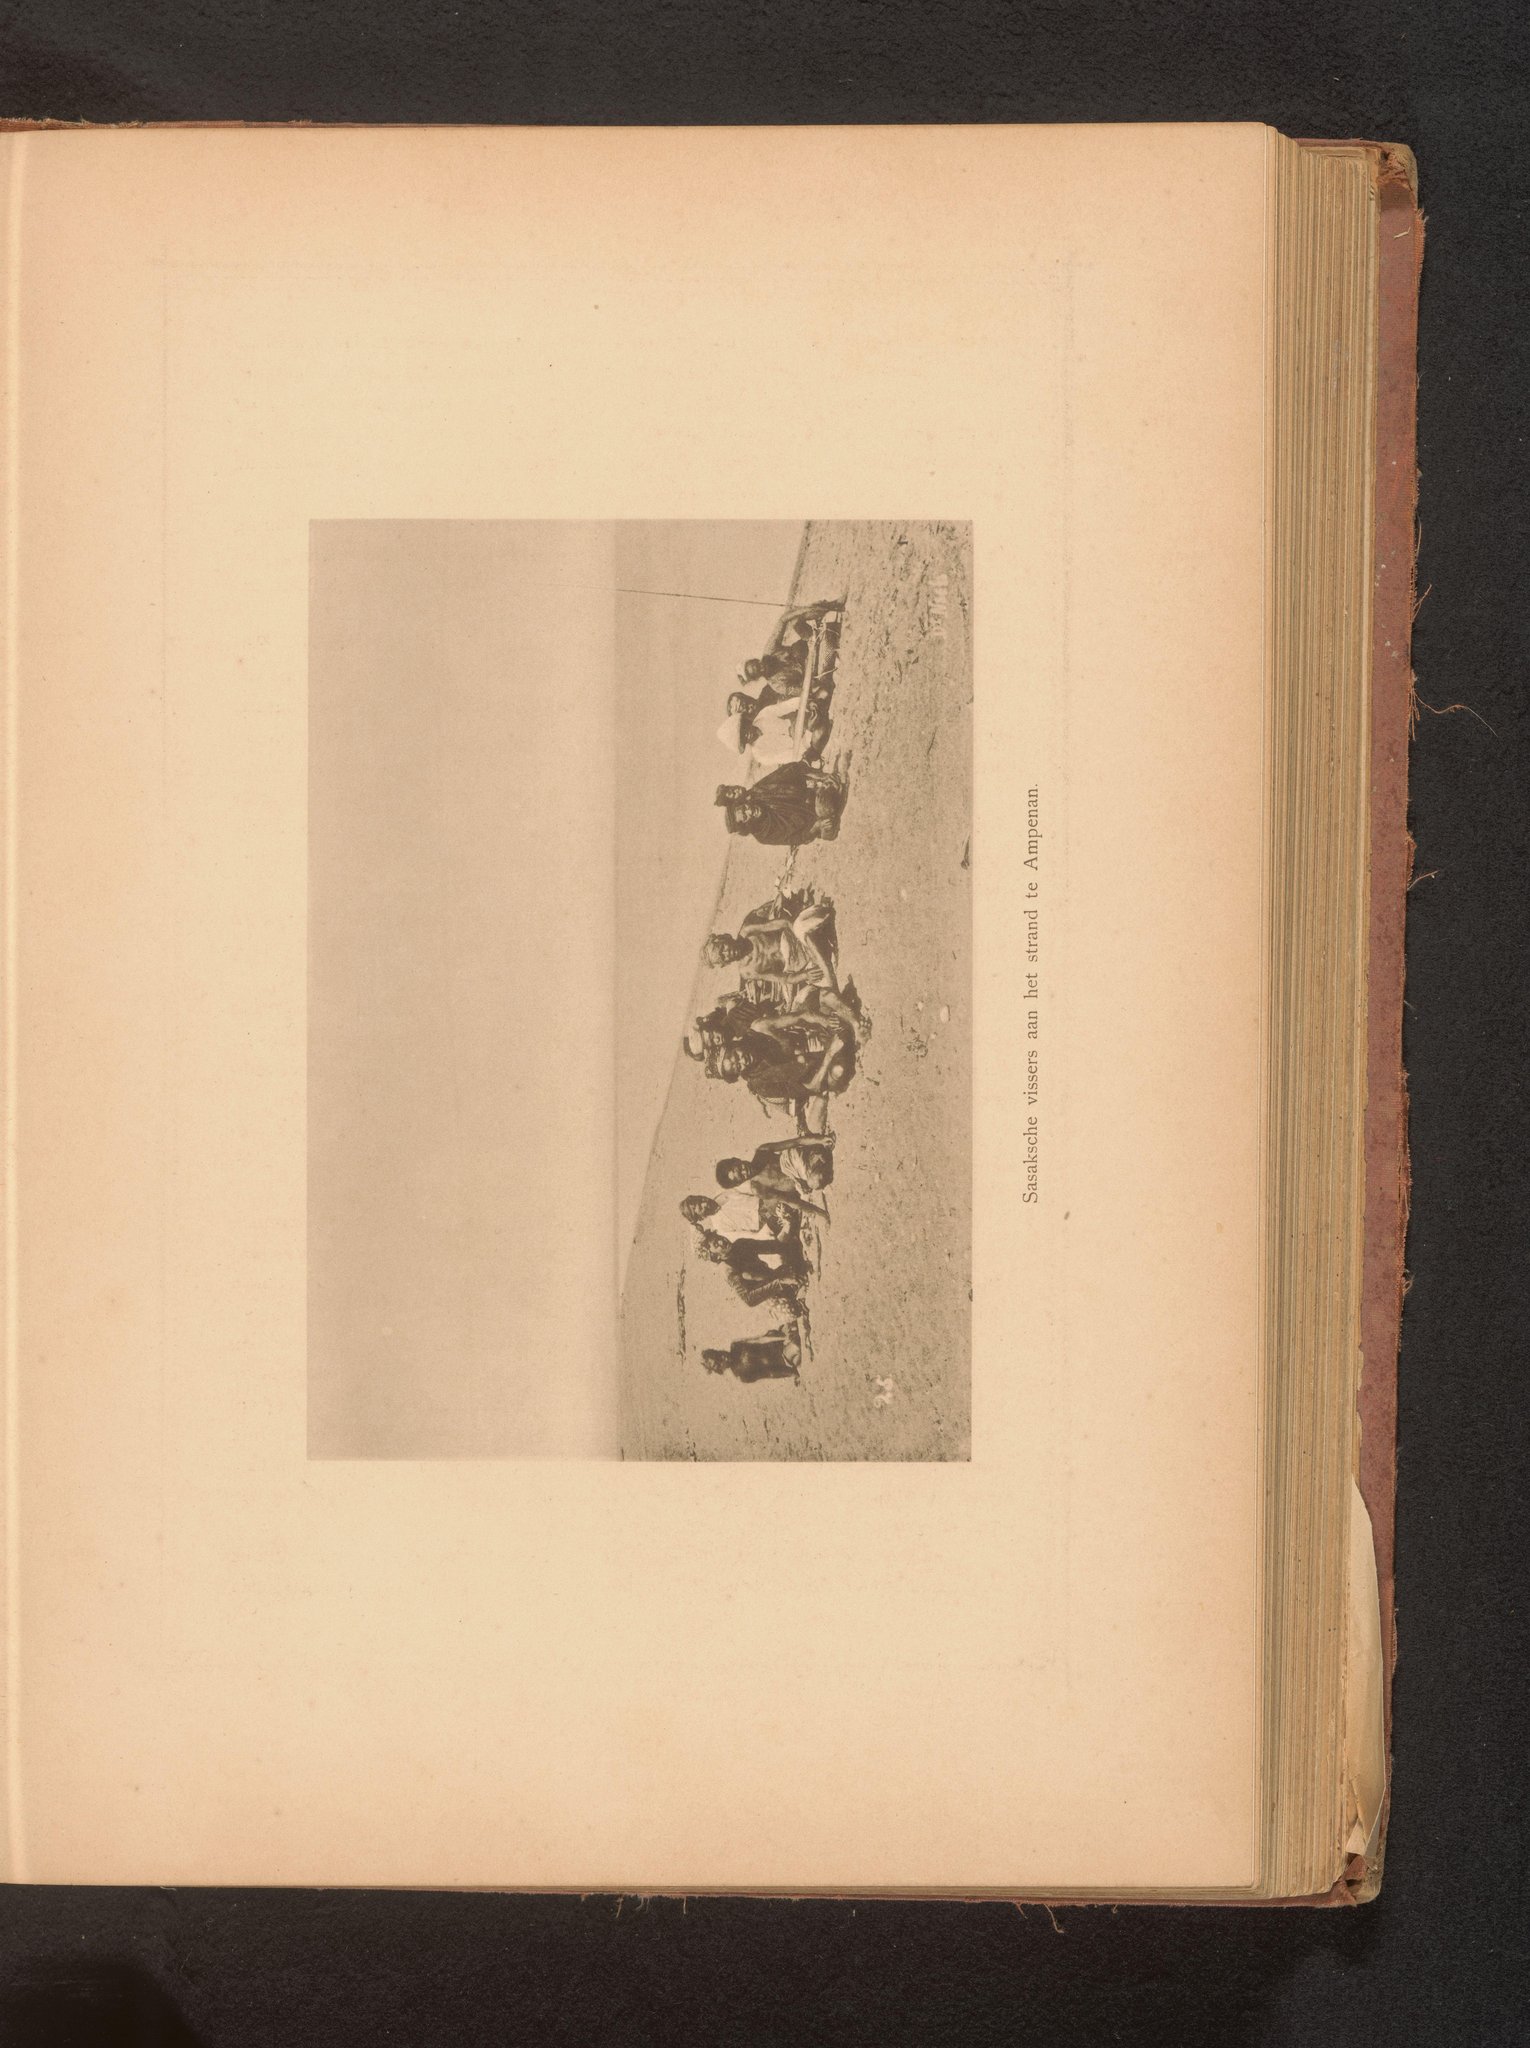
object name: page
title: Sasaksche vissers aan het strand te Ampenan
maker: christiaan johan neeb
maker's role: arts, fotograaf, officier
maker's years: 1860-1925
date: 1892-1897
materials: paper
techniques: photograph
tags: coast, beach, anonymous historical persons portrayed in a group, in a group-portrait